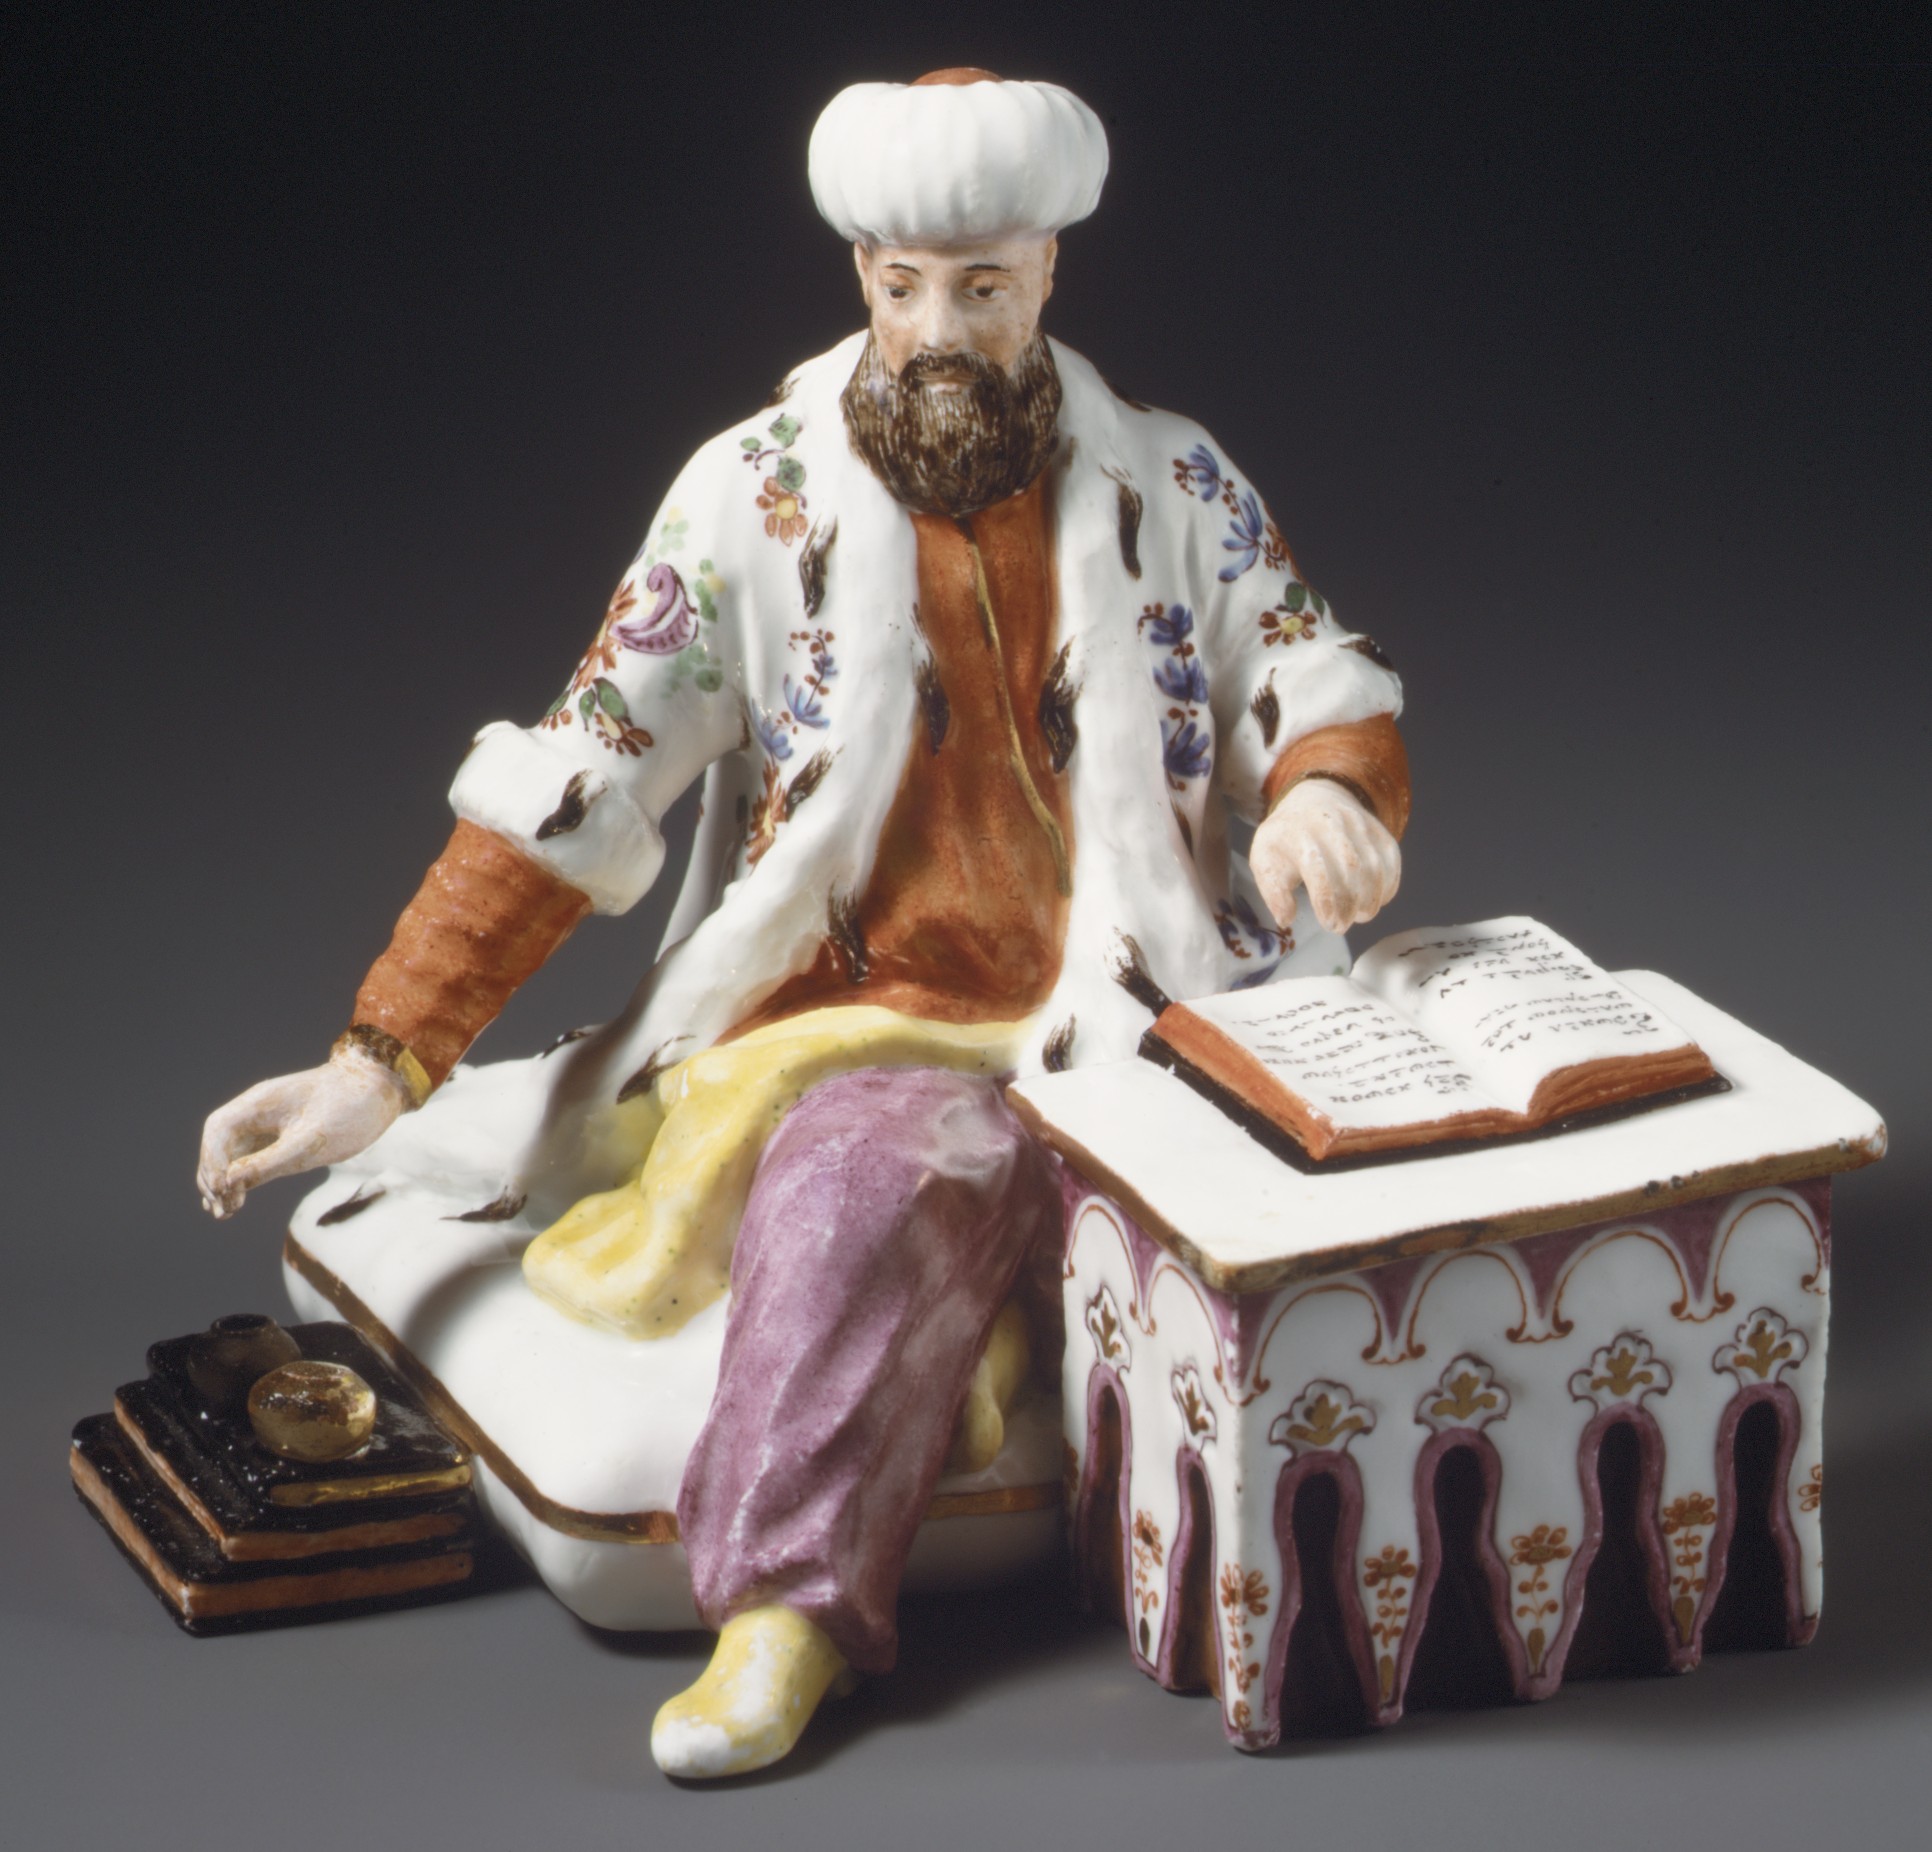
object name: figure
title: An effendi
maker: kloster-veilsdorf porcelain manufactory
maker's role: manufactory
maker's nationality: german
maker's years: 1760-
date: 1770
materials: hard paste porcelain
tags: books,men